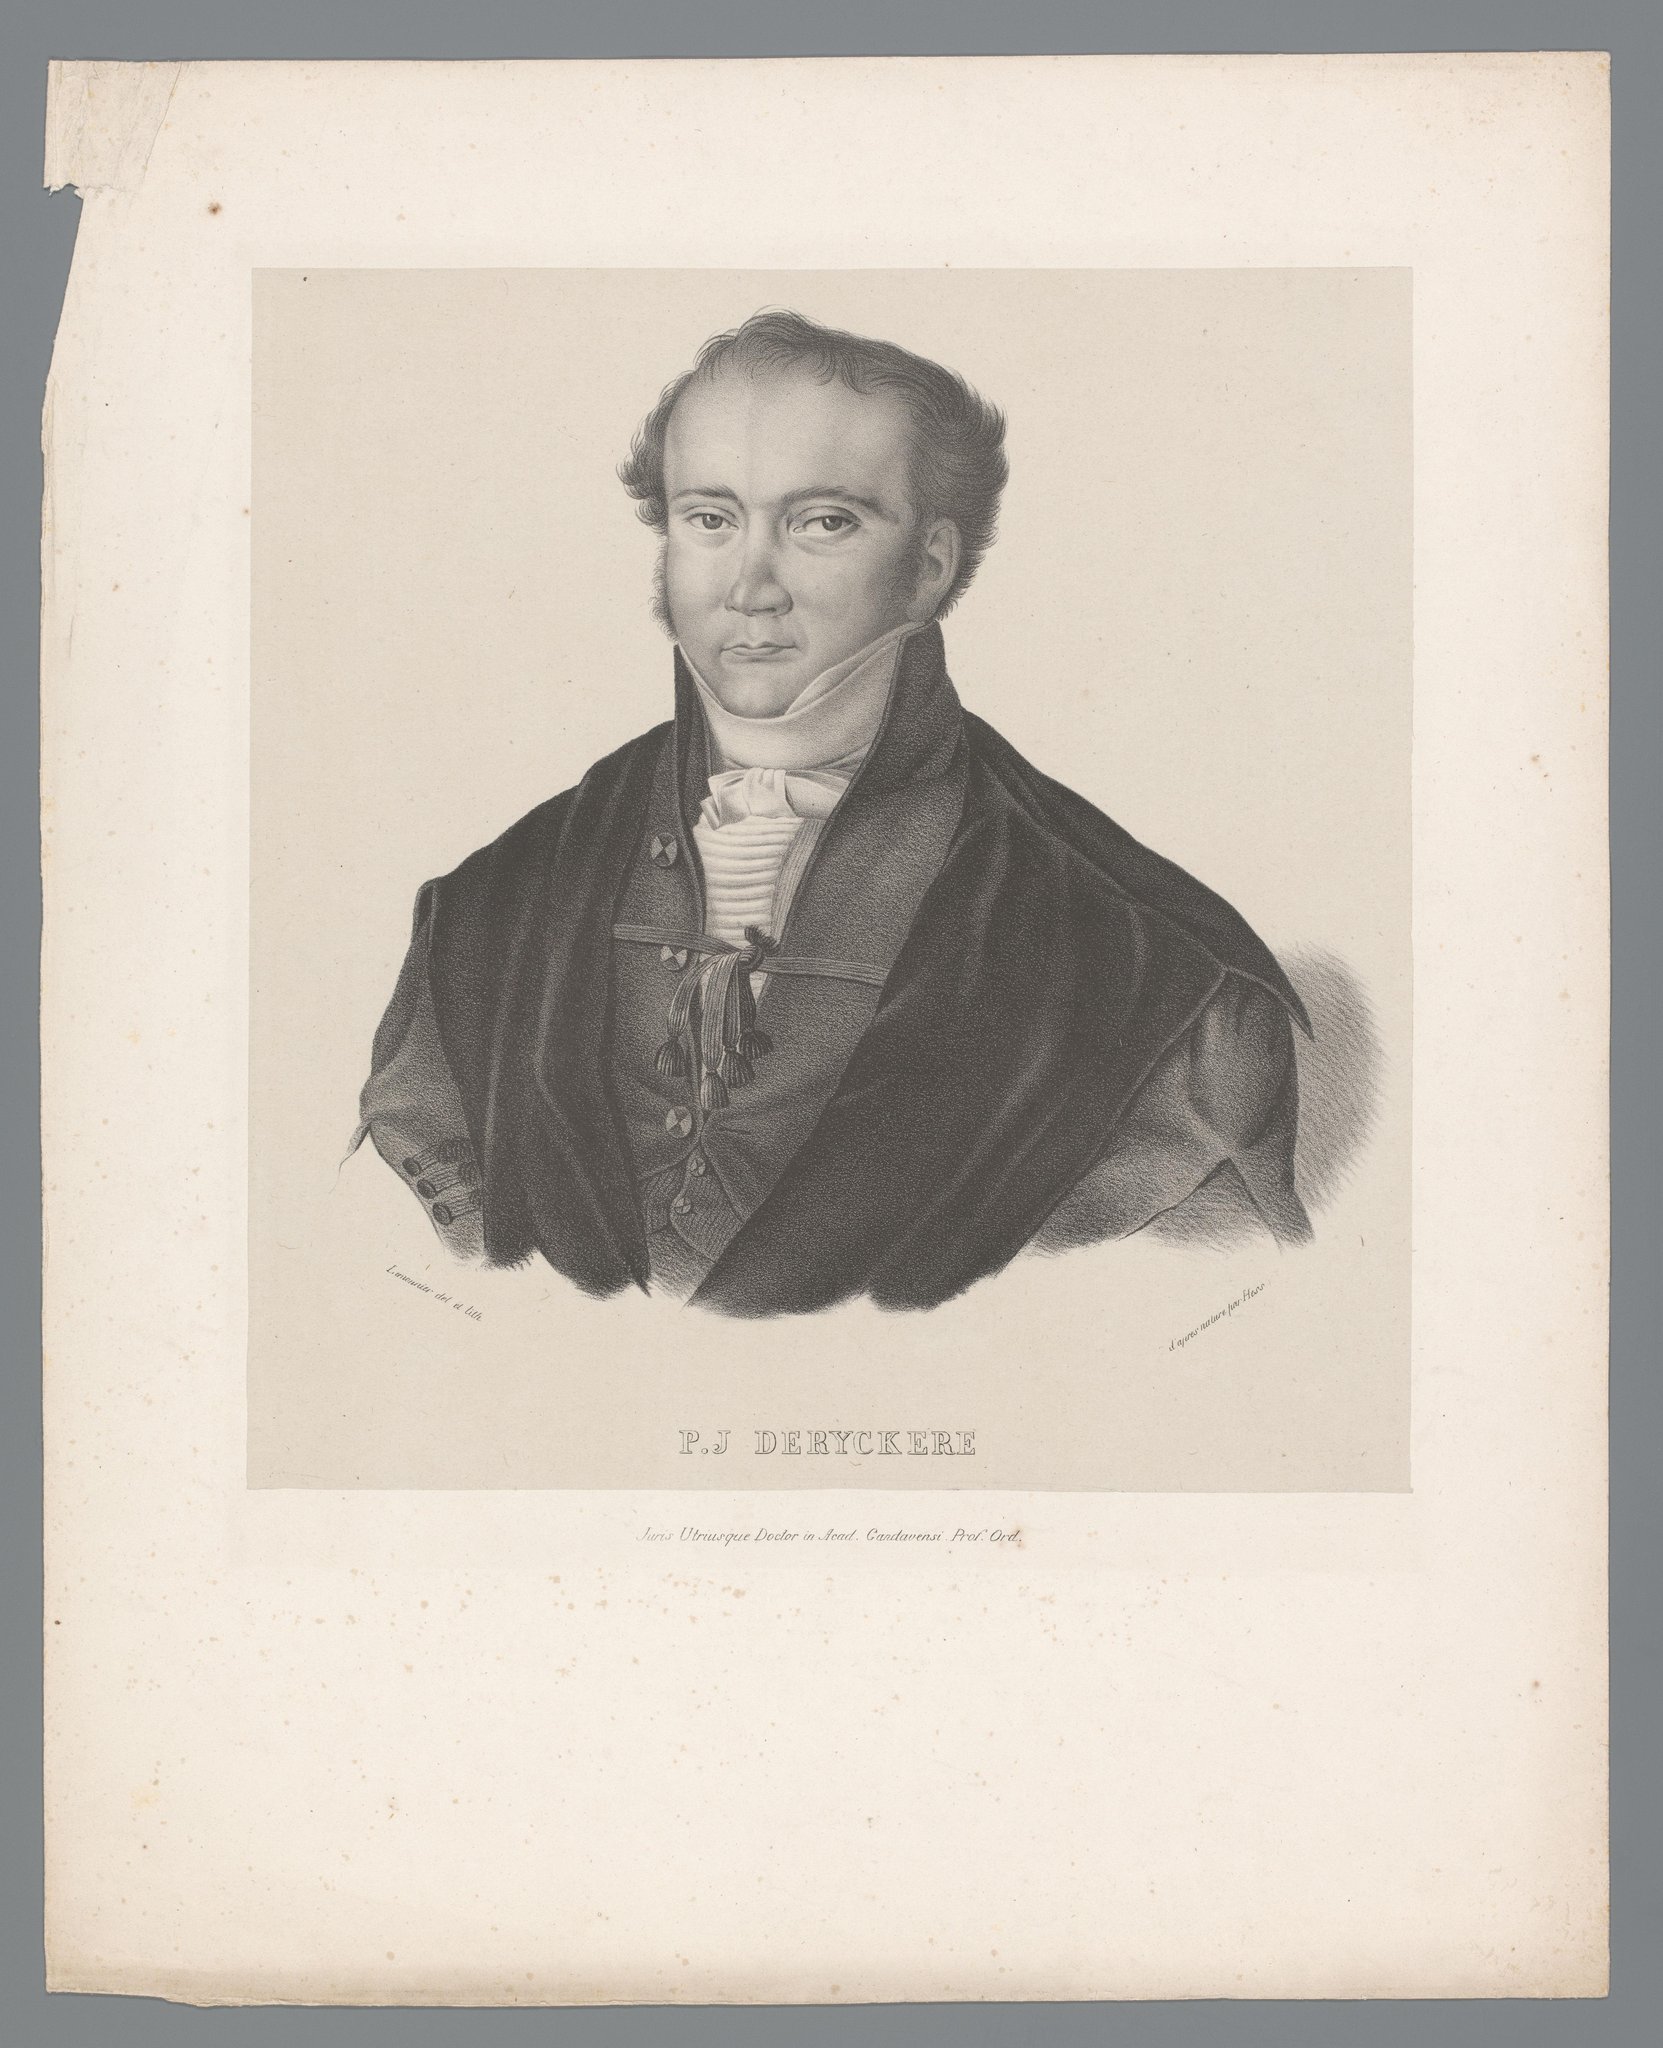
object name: print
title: Portret van Pierre de Ryckere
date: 1827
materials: paper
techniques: lithograph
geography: brussels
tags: ghent, adult man, historical persons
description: Prent verschenen in: Hess, Marcel. Iconographie des professeurs des universites des Pays-Bas. Brussel: Van Someren, 1827.